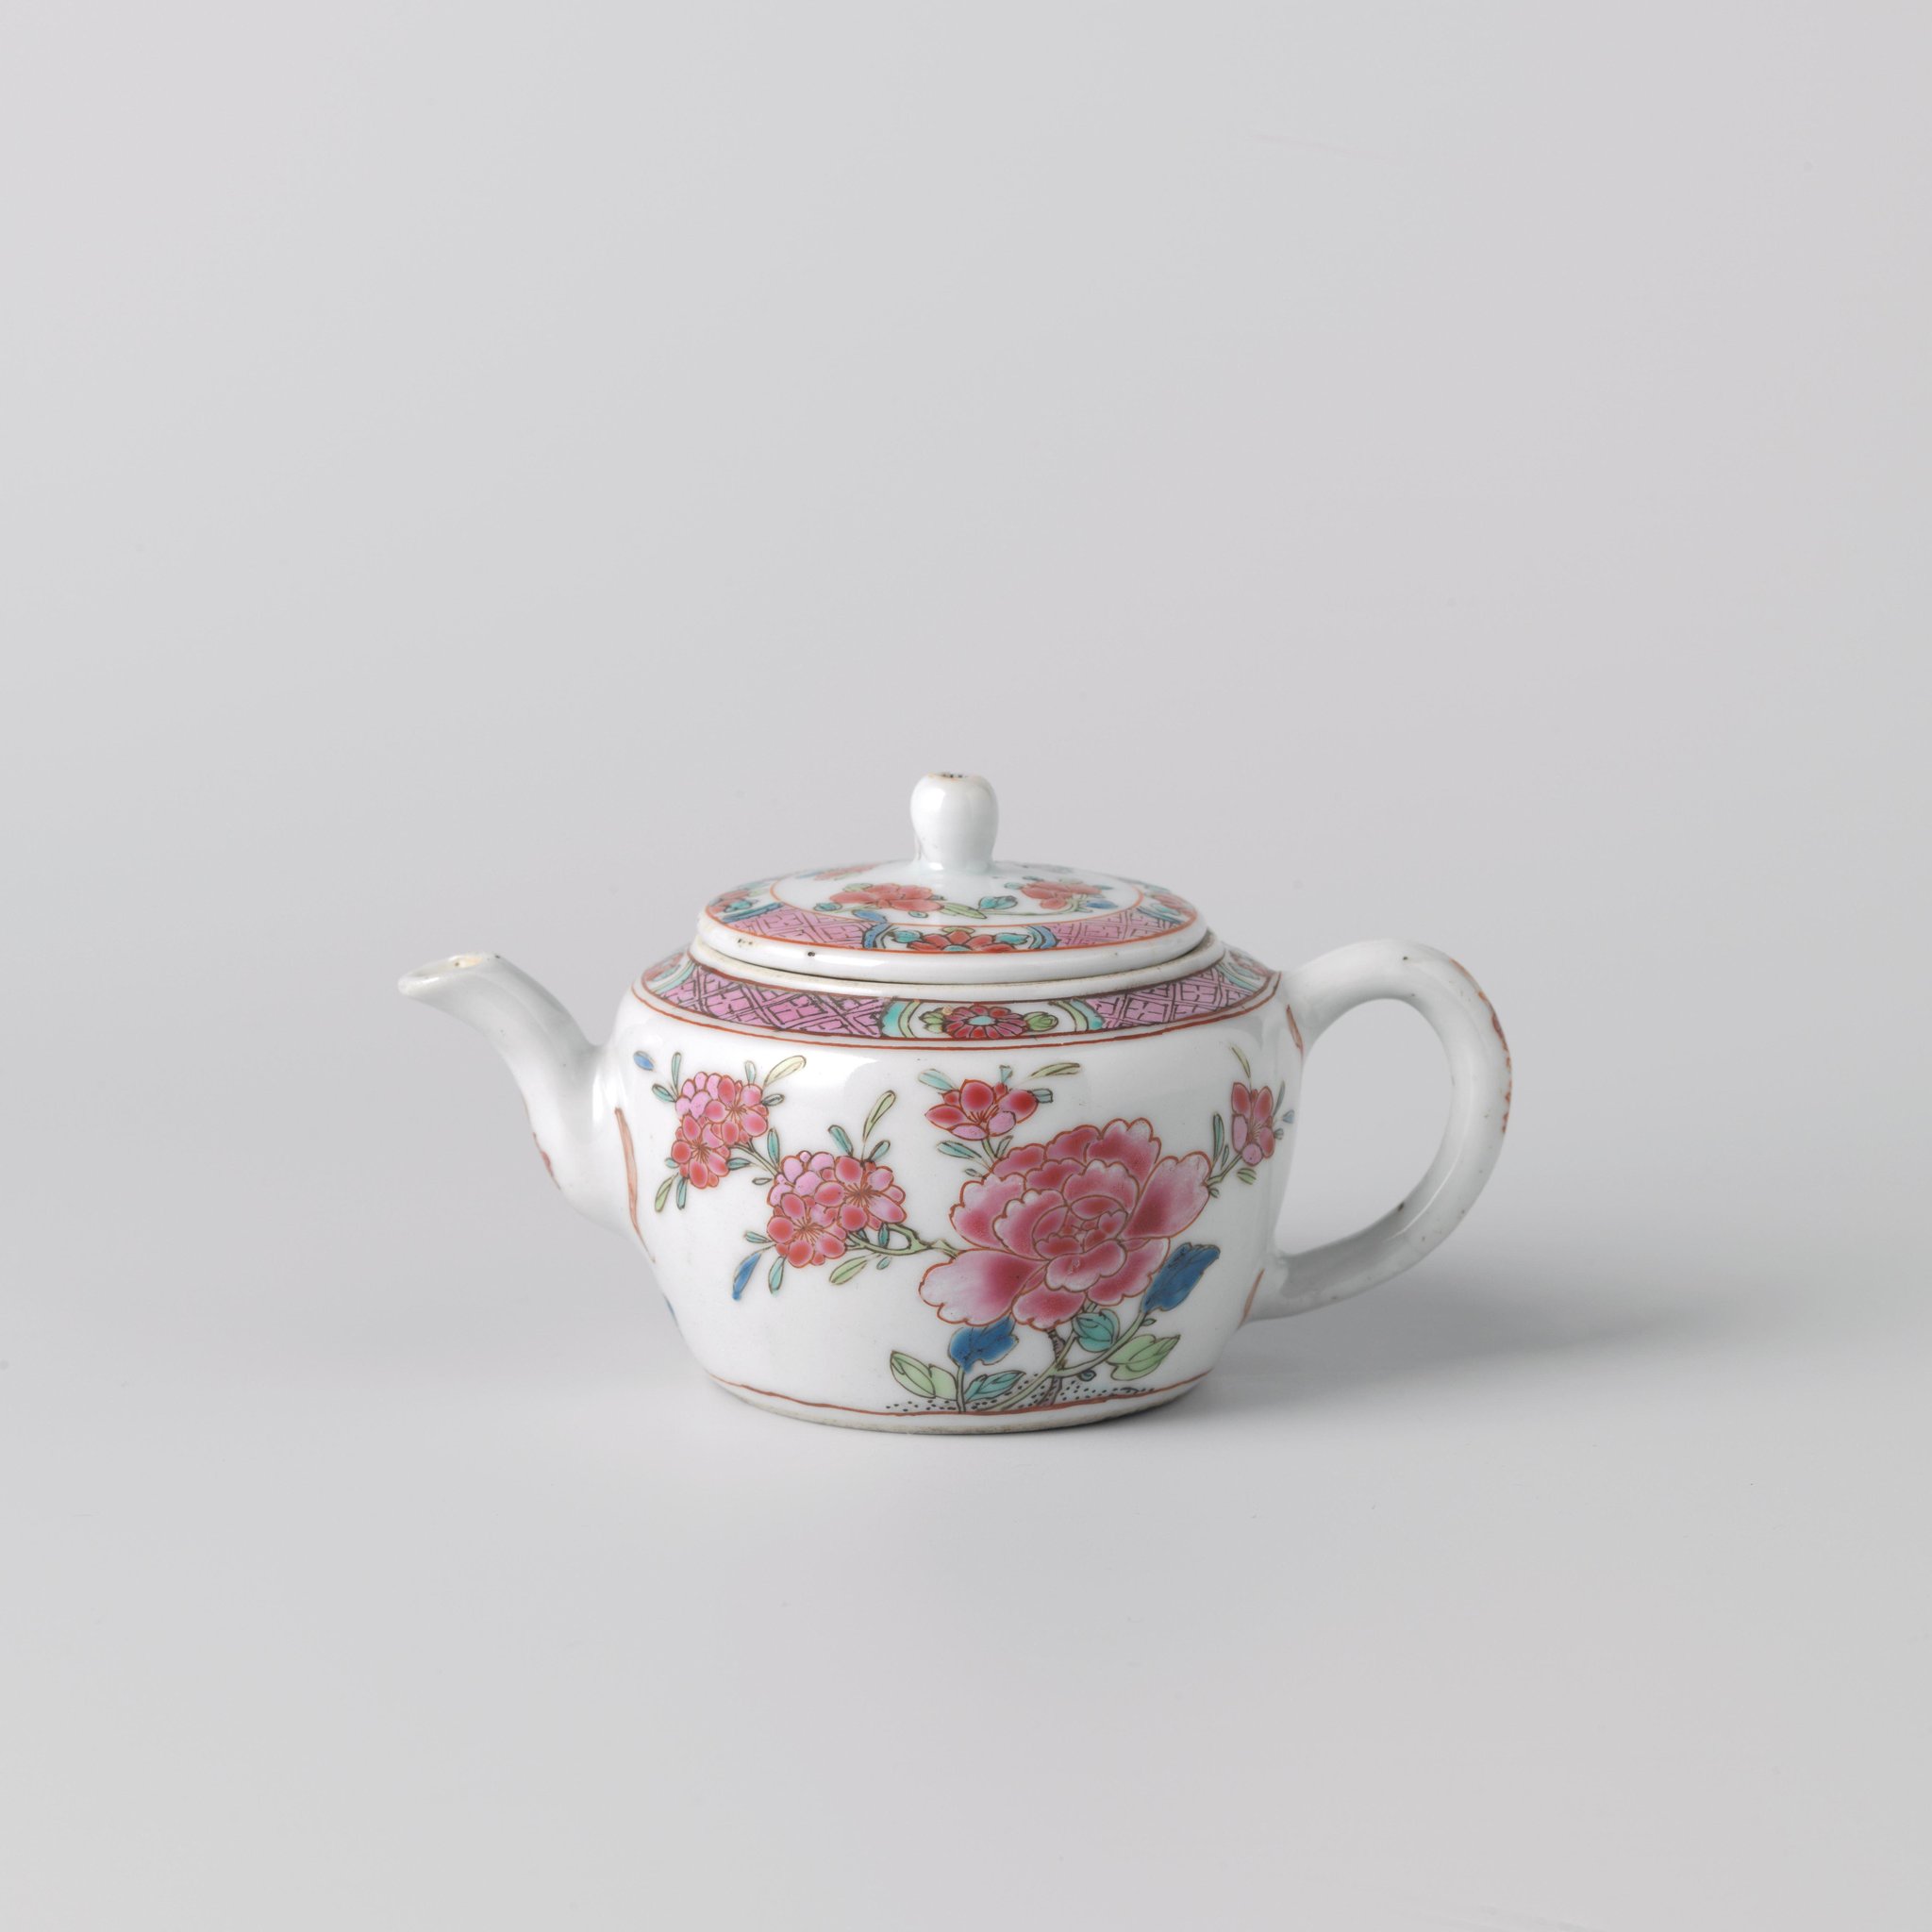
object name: teapot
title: Tea pot with flowering plants and diaper patterns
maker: Anonymous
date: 1725-1749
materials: glaze, paint, porcelain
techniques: firing, turning, vitrification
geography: china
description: Theepot van porselein met een gebogen tuit en C-vormig oor, beschilderd op het glazuur in blauw, rood, roze, groen, turquoise, aubergine en zwart. Op de wand tweemaal een bloeiende plant (pioen). Op de schouder een band met servetwerk onderbroken door bloemtakken in cartouches. De tuit en het oor met bloemranken. De deksel met dezelfde decoratie. Famille rose.